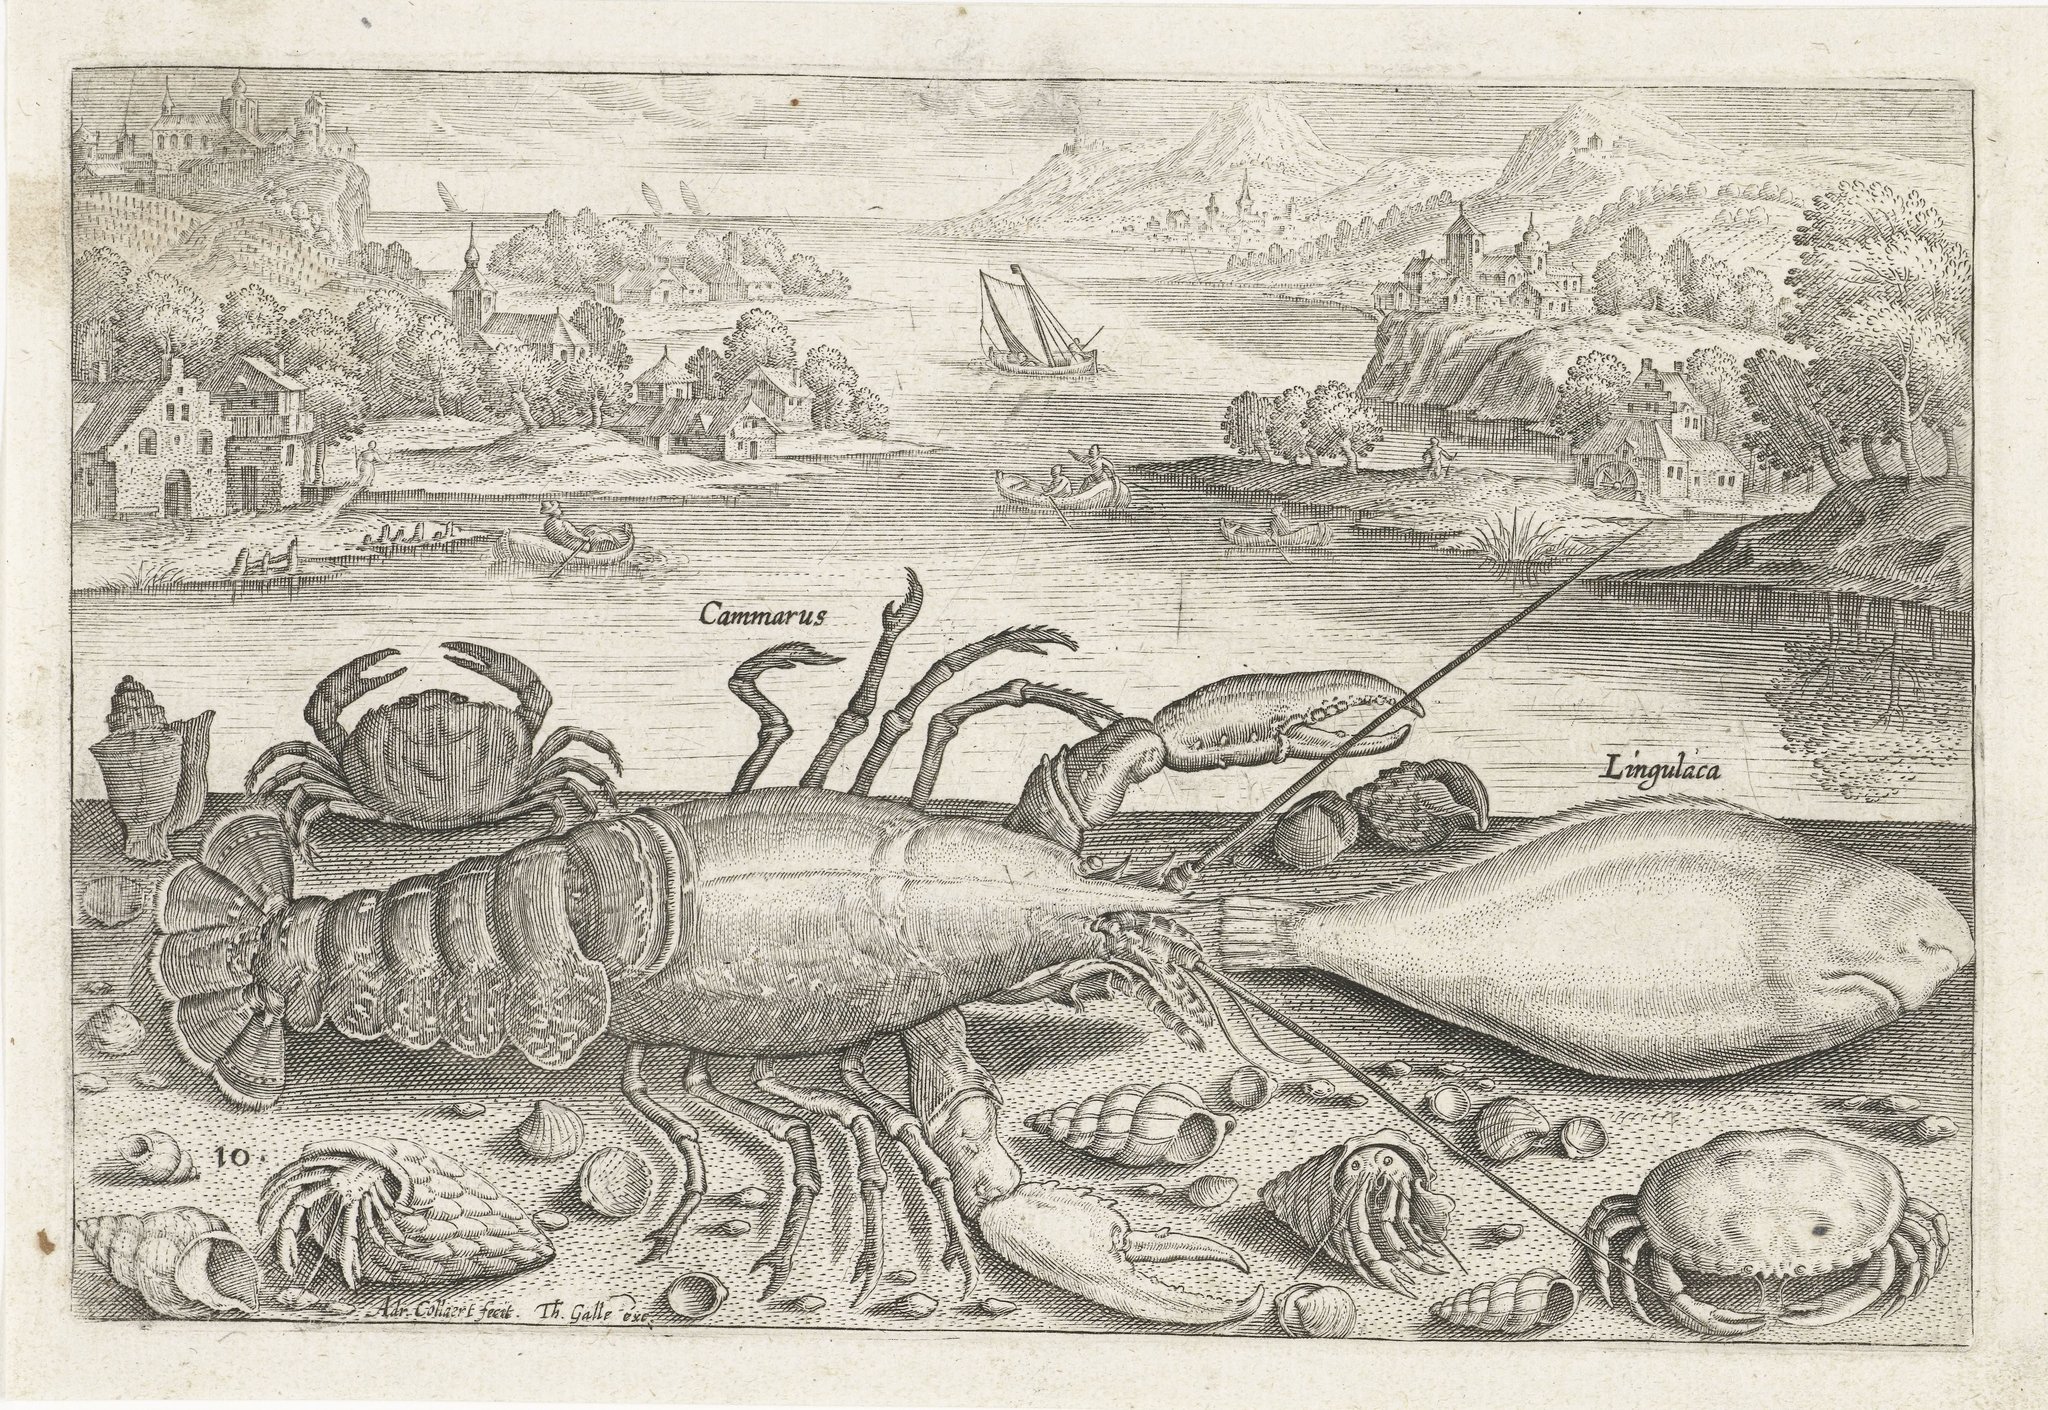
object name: print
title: Piscivm vivae icones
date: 1627-1636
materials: paper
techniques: engraving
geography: antwerp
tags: sea (seascape), crustaceans: crab, crustaceans: lobster, bony fishes: sole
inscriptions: collector's mark: Lugt 2228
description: Een tong, een kreeft, twee krabben en twee heremietkreeften liggen samen met wat schelpen aangespoeld op het strand. Op de achtergrond de zee met enkele schepen. De prent maakt deel uit van een serie met vissen als onderwerp.